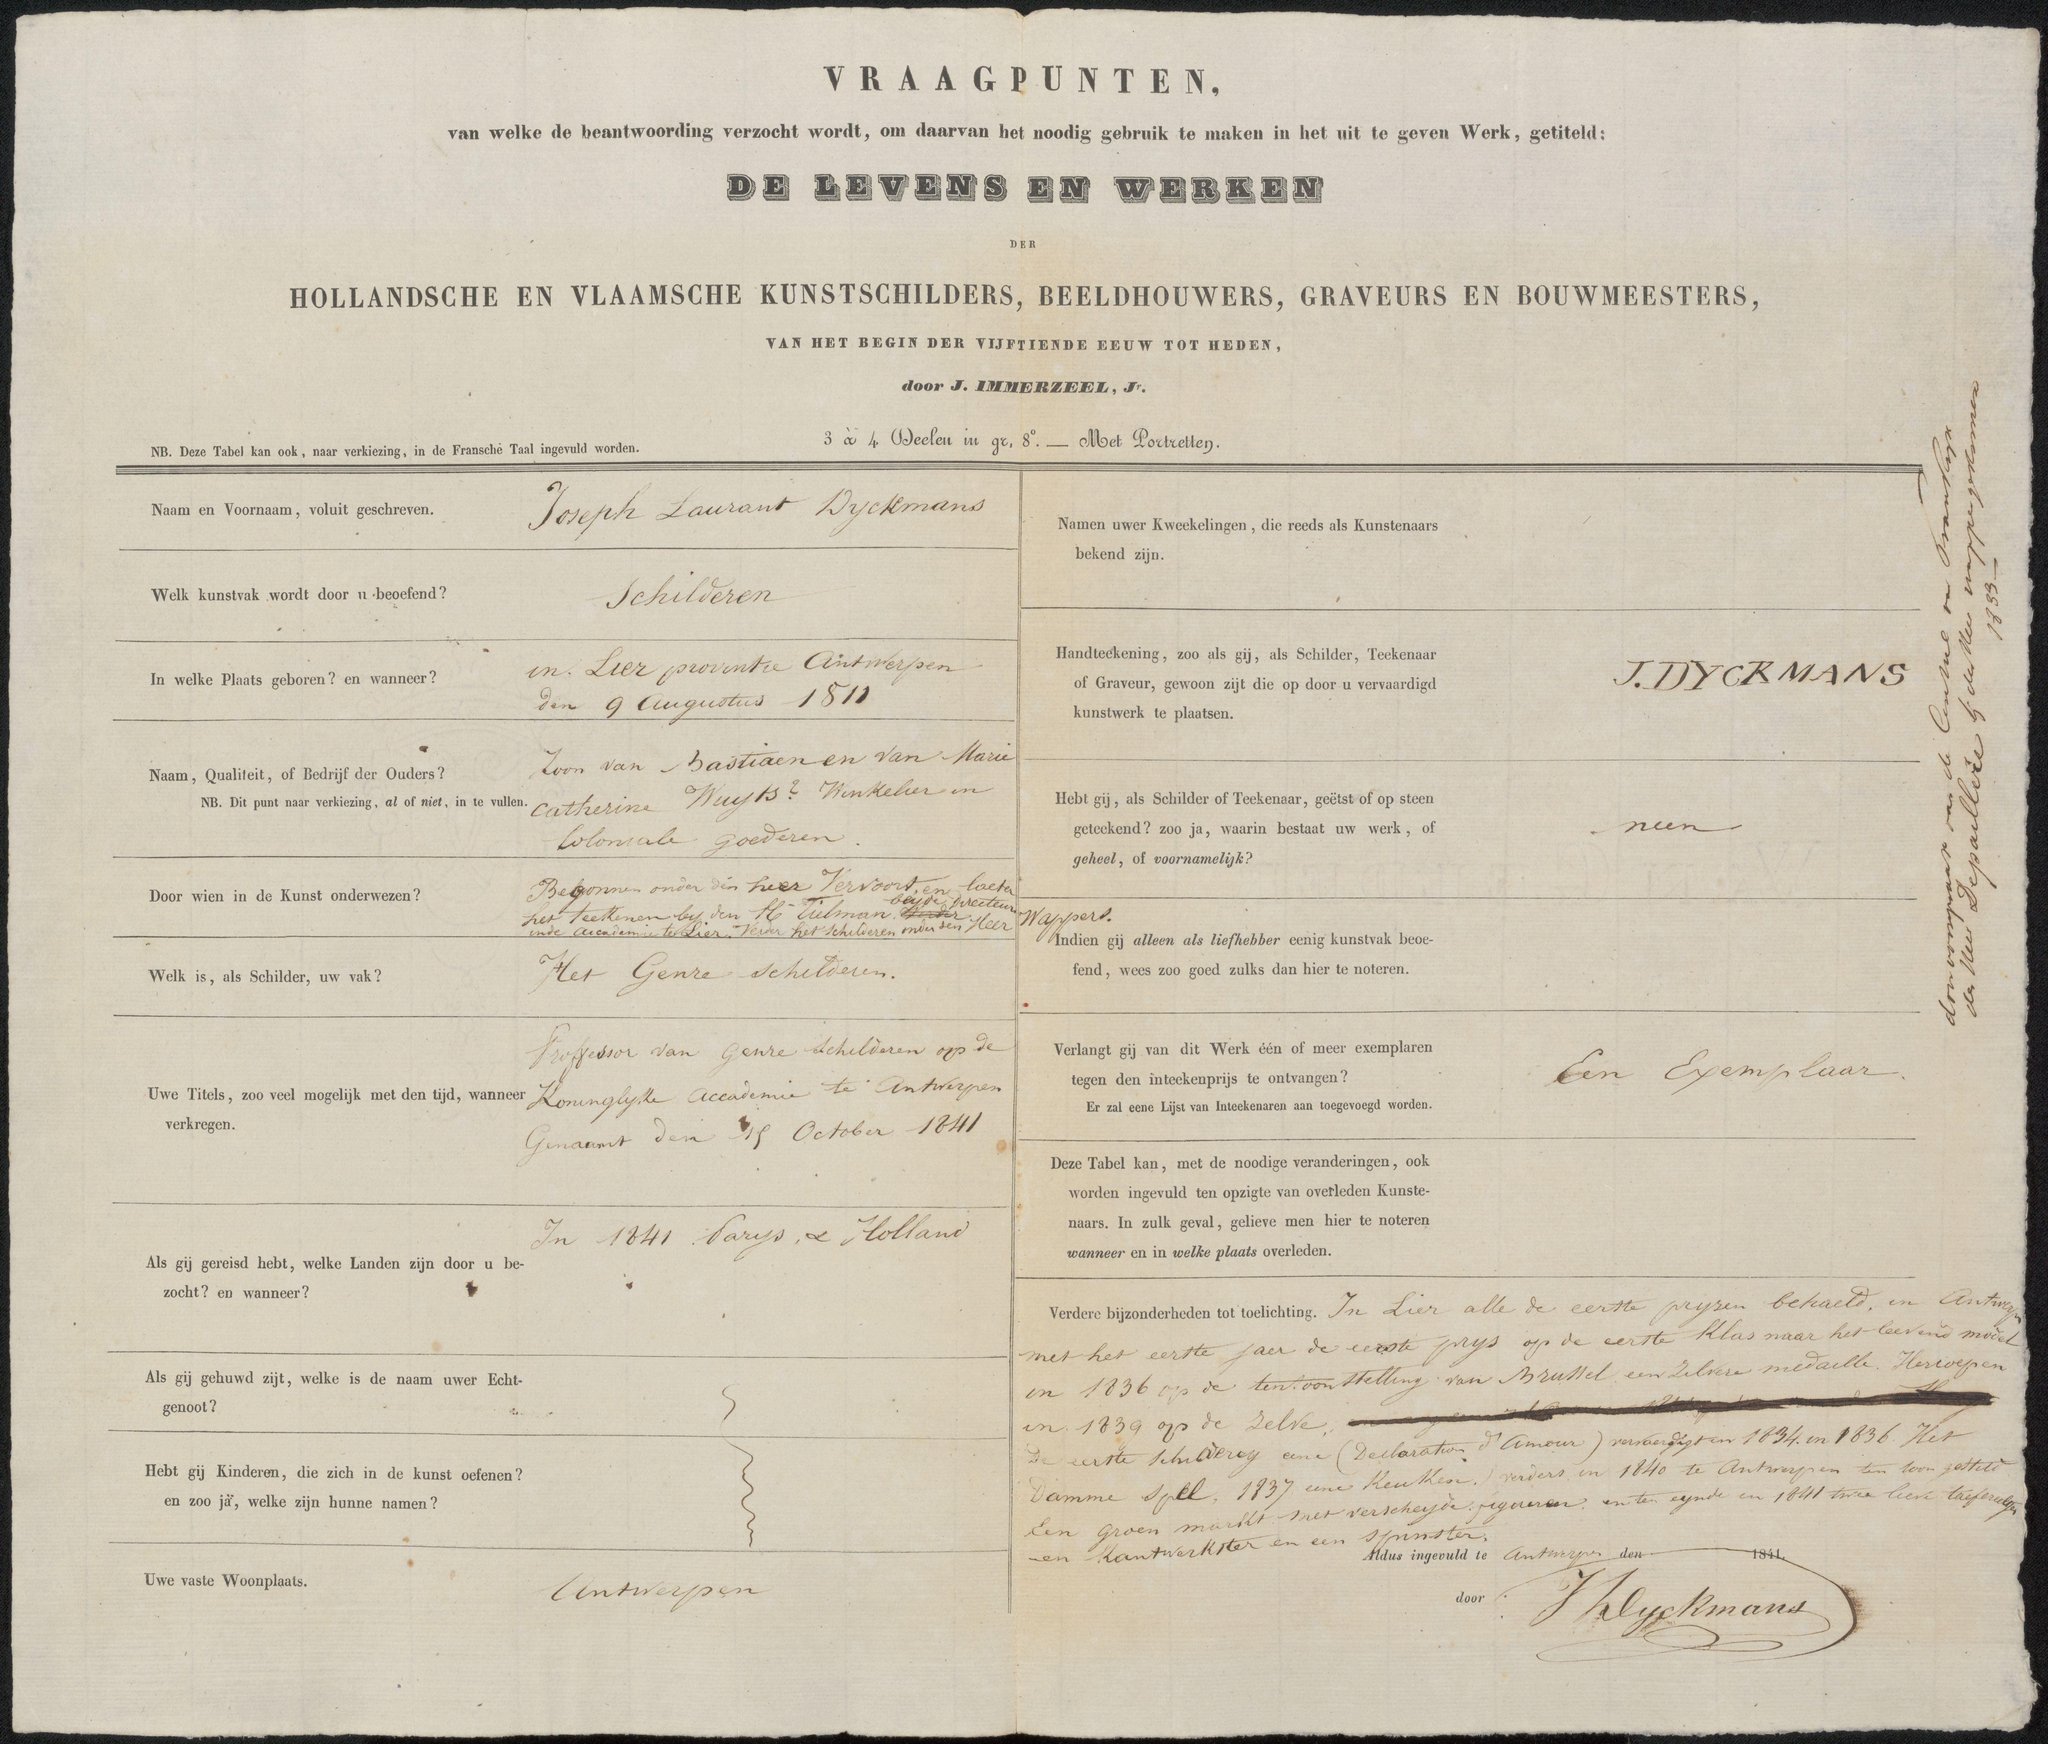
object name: questionnaire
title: Enquêteformulier ingevuld door Jozef Laurent Dyckmans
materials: ink, paper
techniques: pen, printing, writing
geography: antwerp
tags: lierre, antwerp, artist, jozef laurent dyckmans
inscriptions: watermark, inscription: ‘Vraagpunten,/ van welke de beantwoording verzocht wordt, om daarvan het noodig gebruik te maken in het uit te geven Werk, getiteld: De levens en werken/ der Hollandsche en Vlaamsche kunstschilders, beeldhouwers,/ graveurs en bouwmeesters, van het begin der vijftiende eeuw tot heden/ door J. Immerzeel, Jr.’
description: Opgenomen in: Immerzeel, J. Jr., De levens en werken der Hollandsche en Vlaamsche kunstschilders, beeldhouwers, graveurs en bouwmeesters, van het begin der vijftiende eeuw tot heden, Amsterdam: J.C. van Kesteren, 1842-1843.